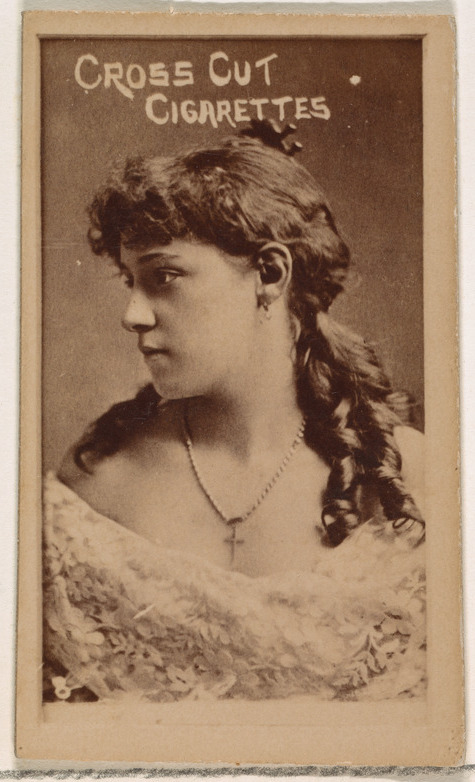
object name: print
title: Card Number 8, from the Actors and Actresses series (N145-1) issued by Duke Sons & Co. to promote Cross Cut Cigarettes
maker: w. duke, sons & co.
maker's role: publisher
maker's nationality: american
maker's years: 1870-1920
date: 1880-1889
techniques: albumen silver print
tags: profiles,women,actresses